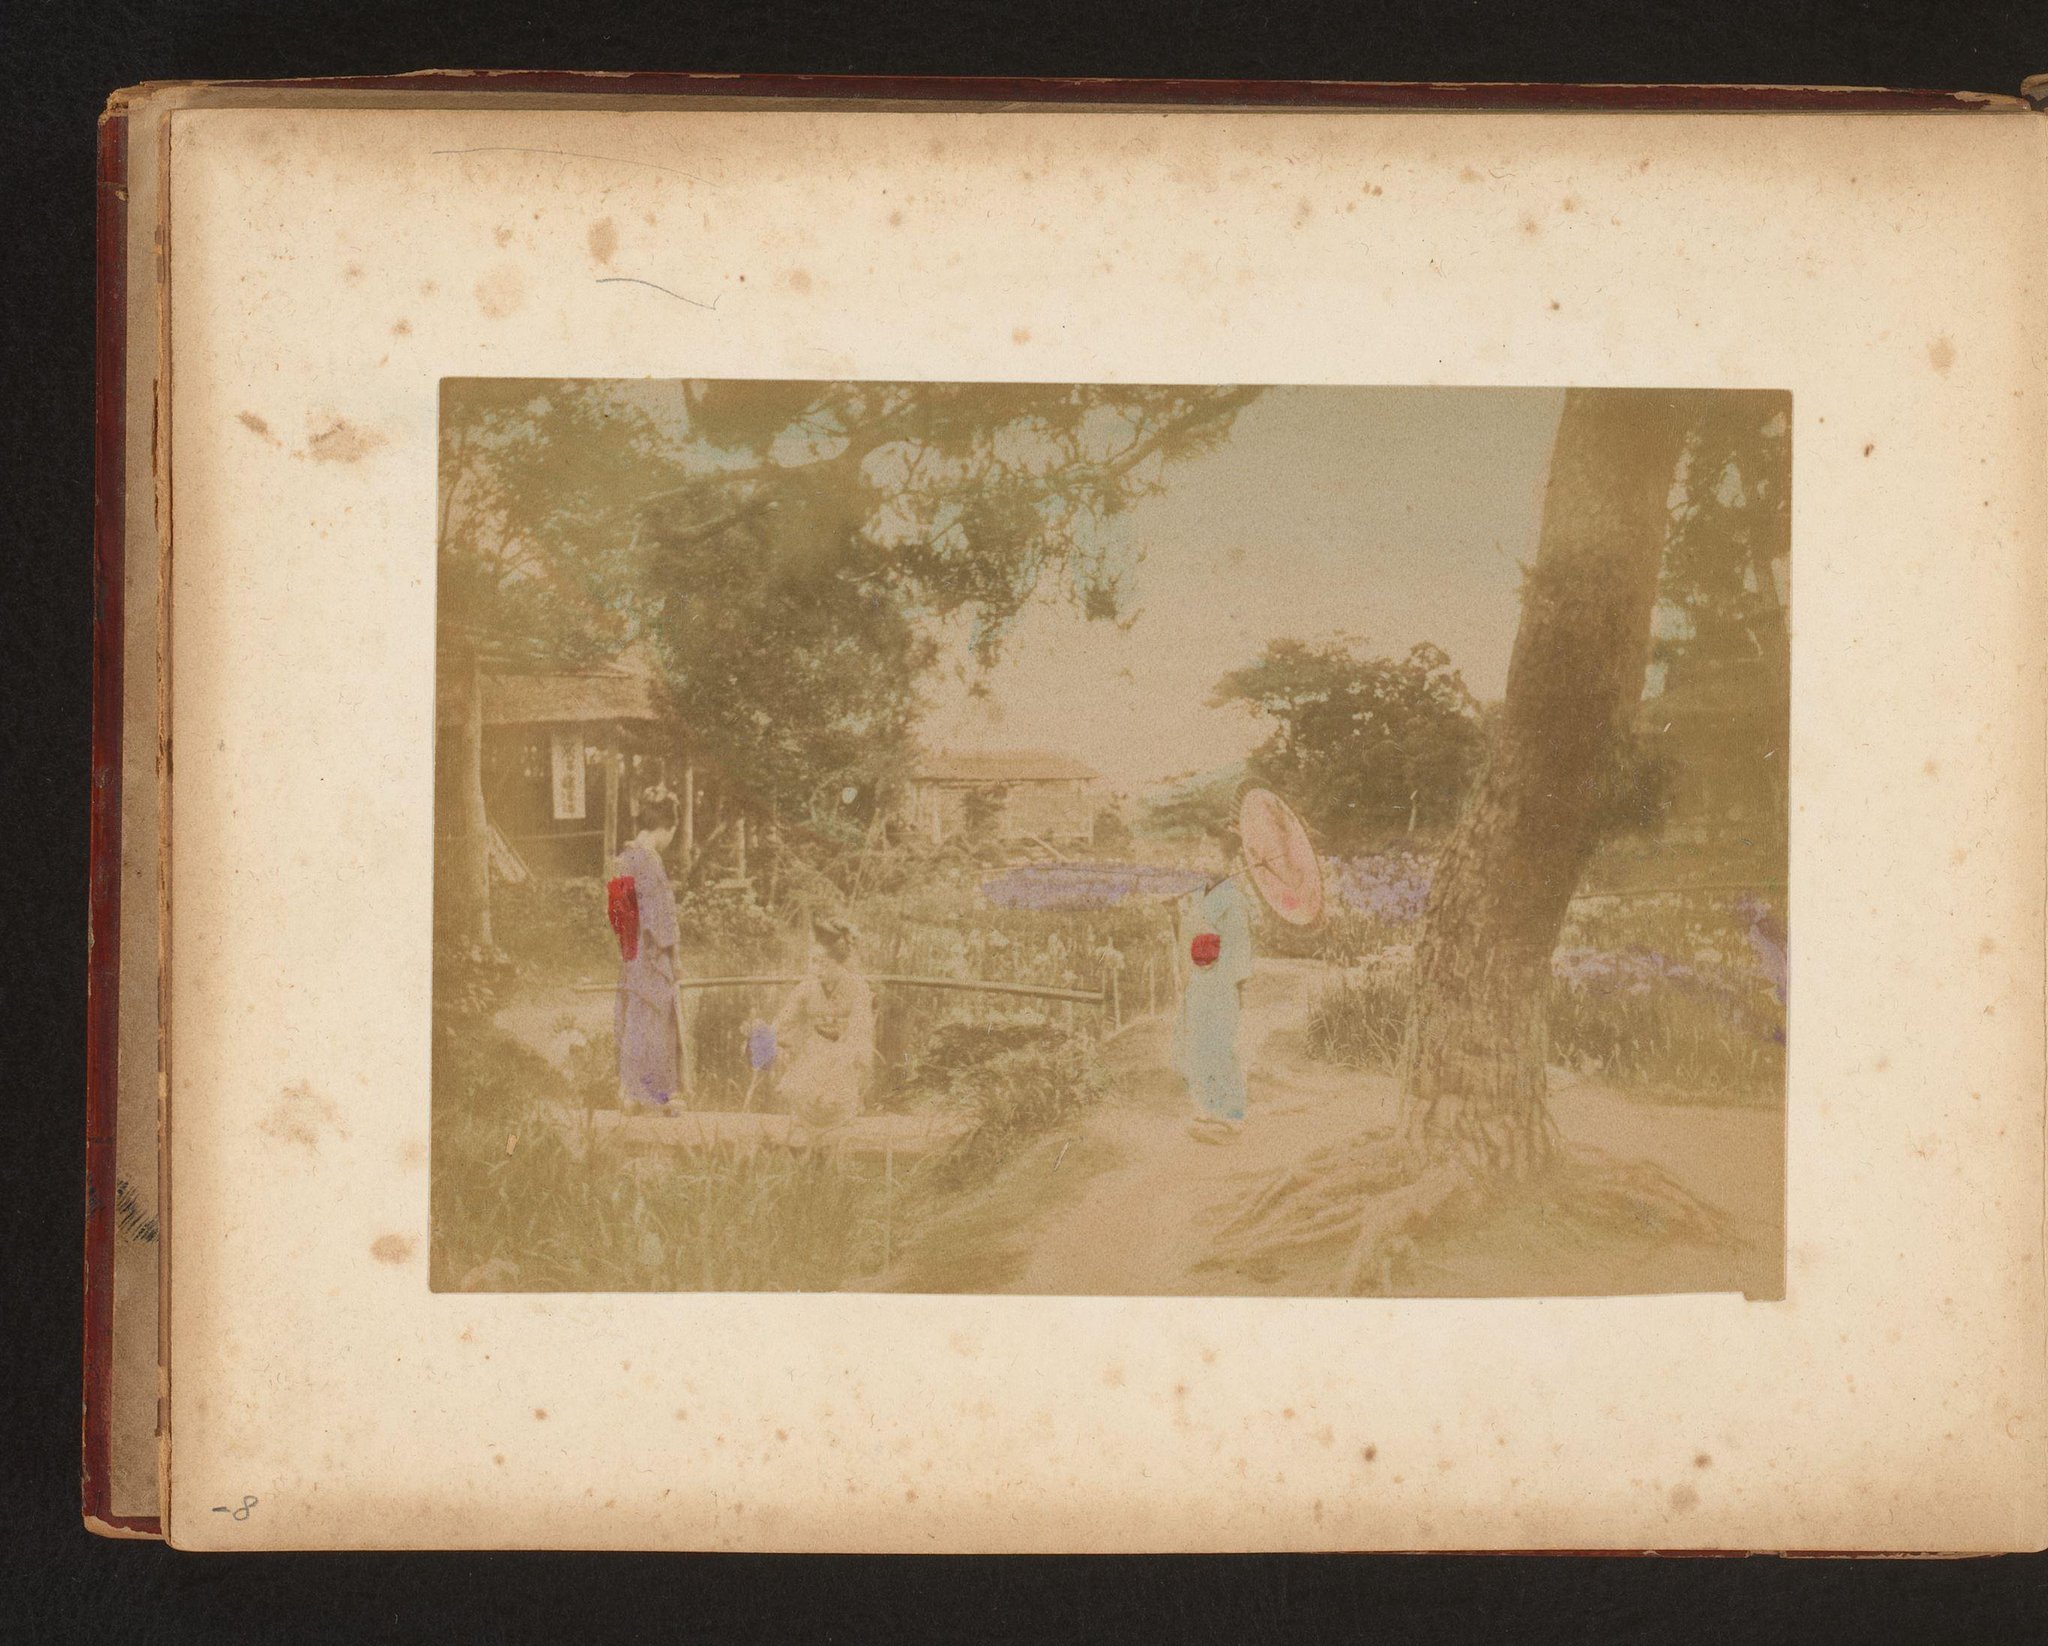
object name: photograph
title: Drie meisjes in een tuin in Japan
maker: Anonymous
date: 1851-1900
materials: paper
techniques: albumen print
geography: japan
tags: girl (child between toddler and youth), japan